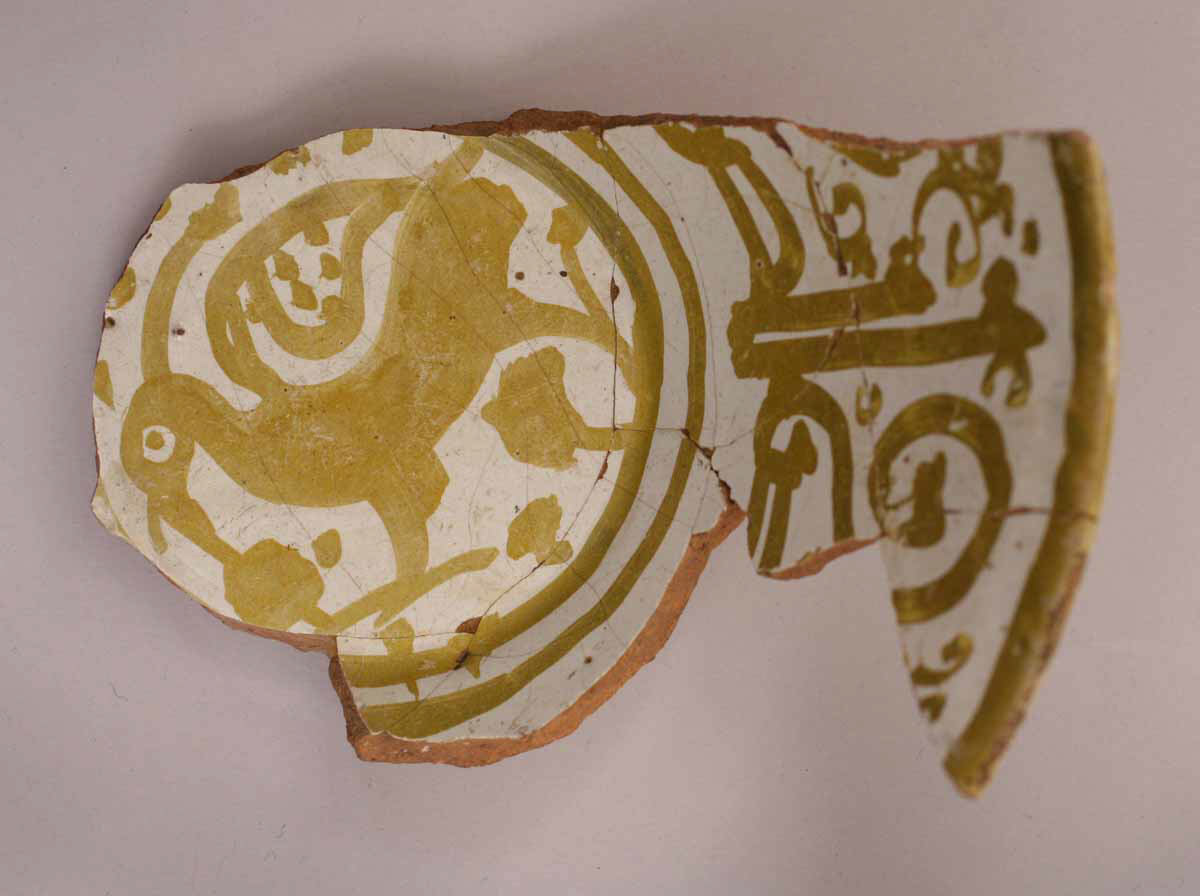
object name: fragment of a bowl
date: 1000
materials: earthenware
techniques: luster painting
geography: egypt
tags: animals